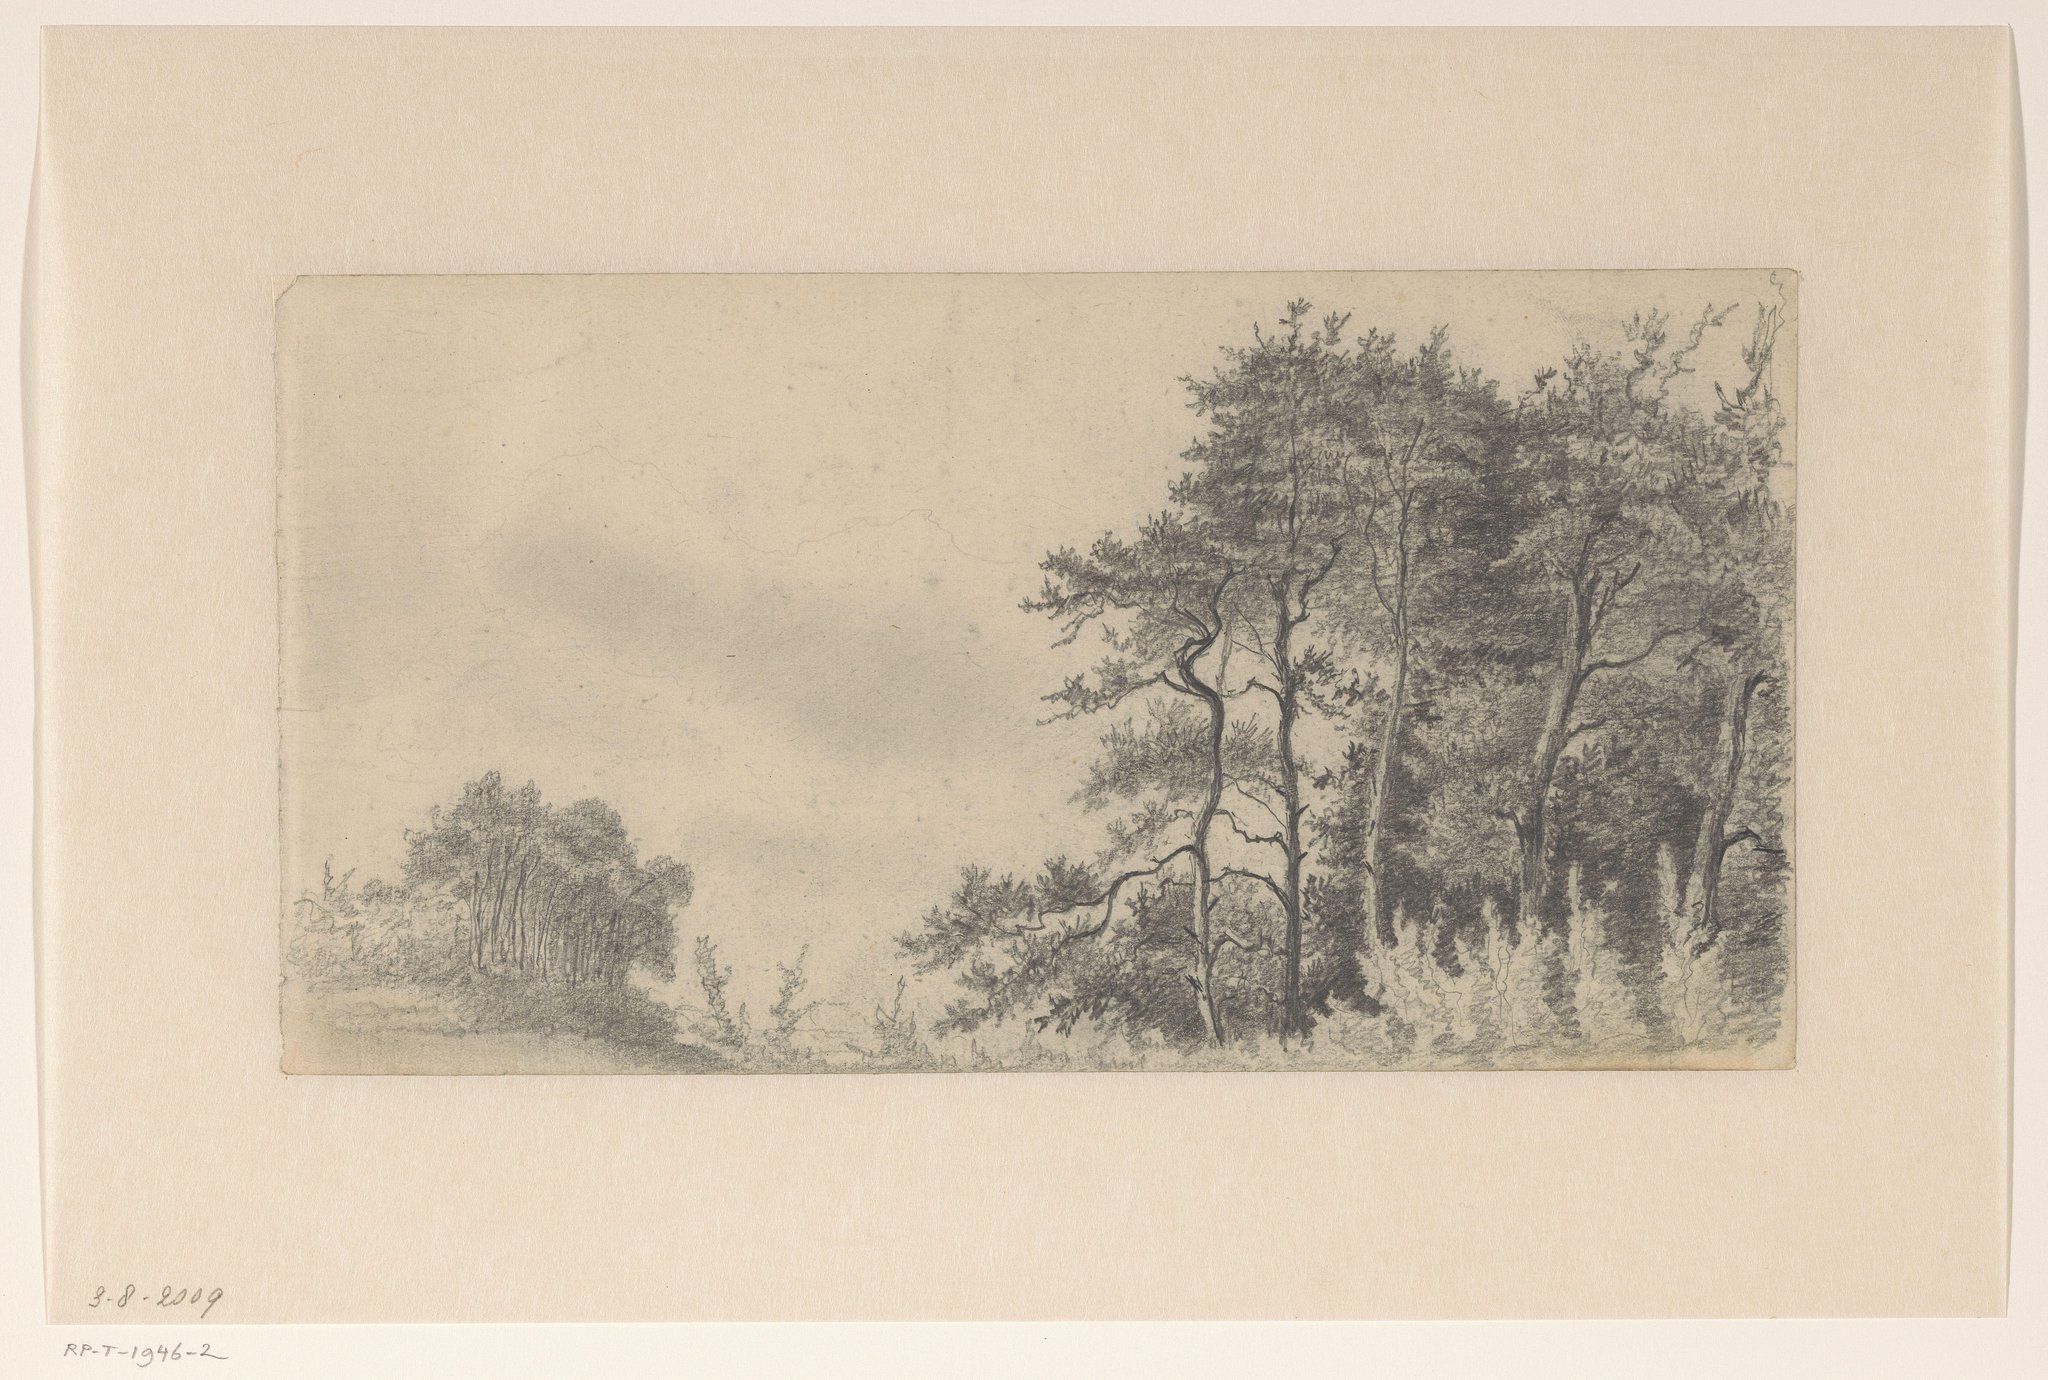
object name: drawing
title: Bosgezicht te Klarenbeek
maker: jan frederik tack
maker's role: draughtsman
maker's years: 1815-1868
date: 1825-1868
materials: paper, pencil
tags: forest, wood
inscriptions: date: ‘dingsdag 15 Juny’